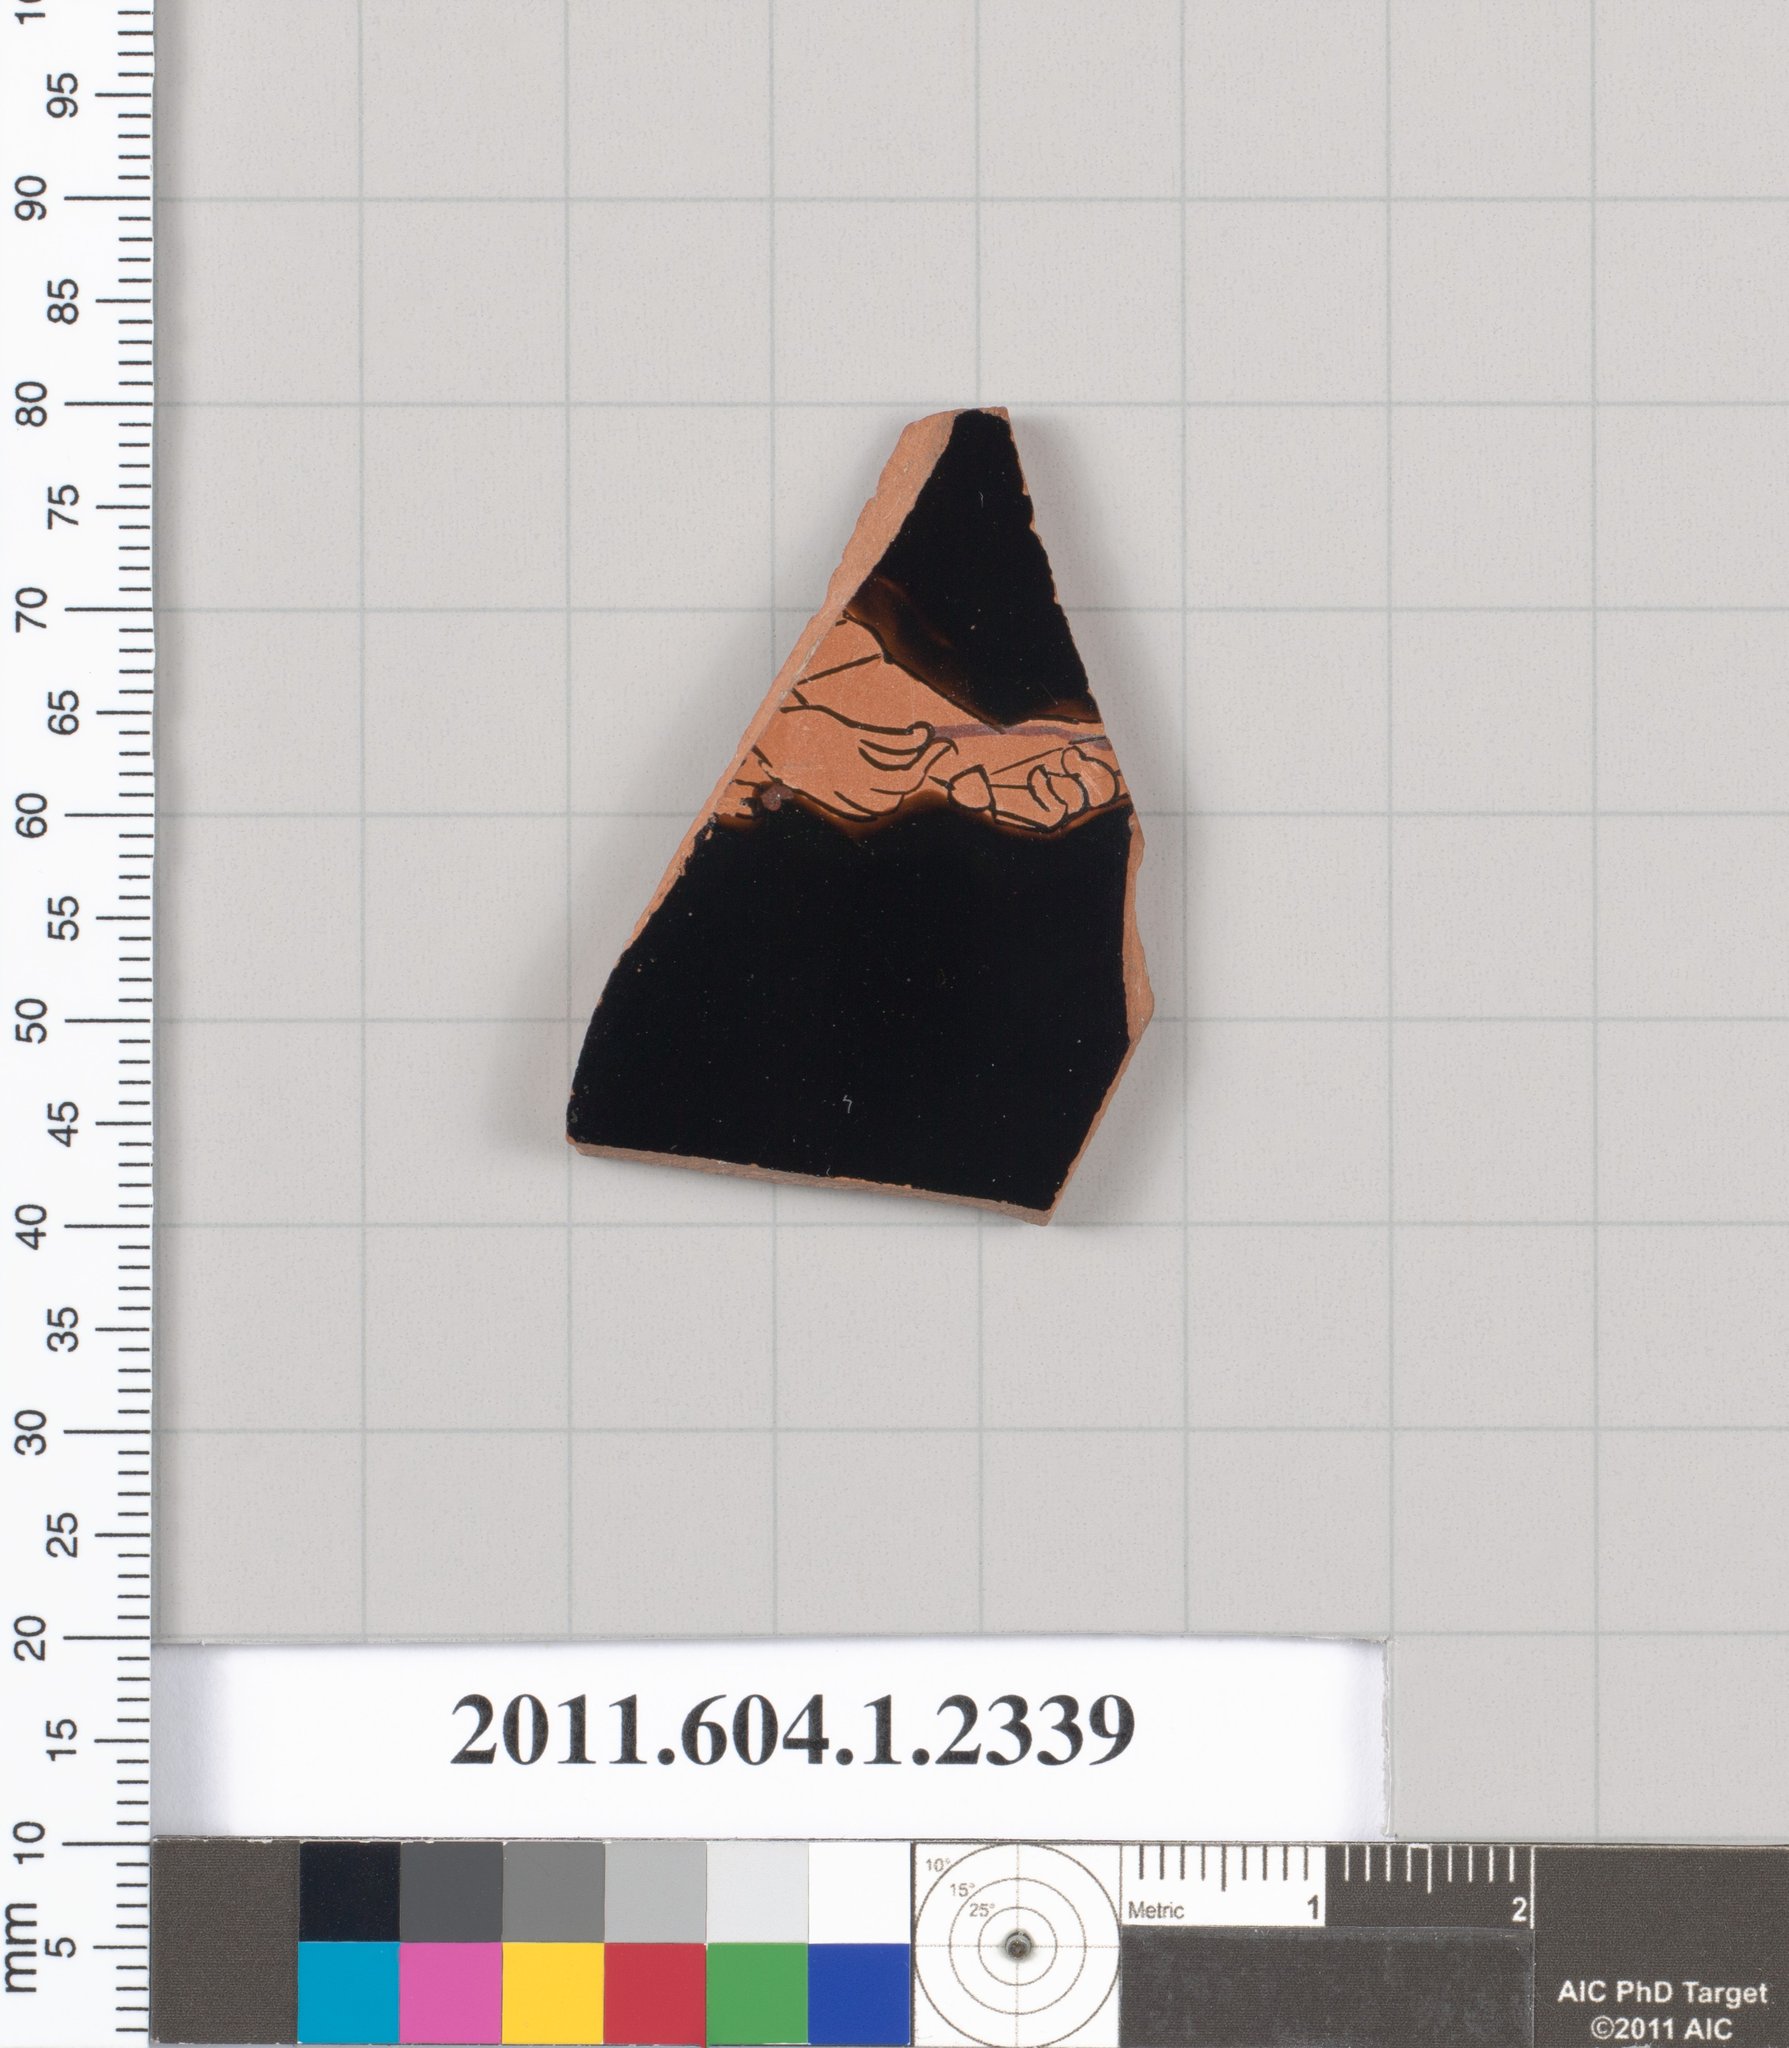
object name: kylix fragment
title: Terracotta fragment of a kylix (drinking cup)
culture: greek, attic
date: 490-480 BCE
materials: terracotta